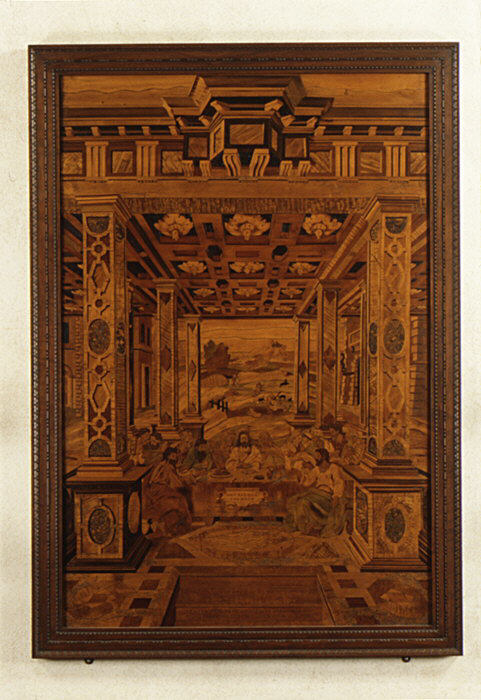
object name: panel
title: The Last Supper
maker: fra damiano da bergamo (damiano di antoniolo de zambelli)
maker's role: maker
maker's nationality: italian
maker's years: 1480-1549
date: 1548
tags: last supper